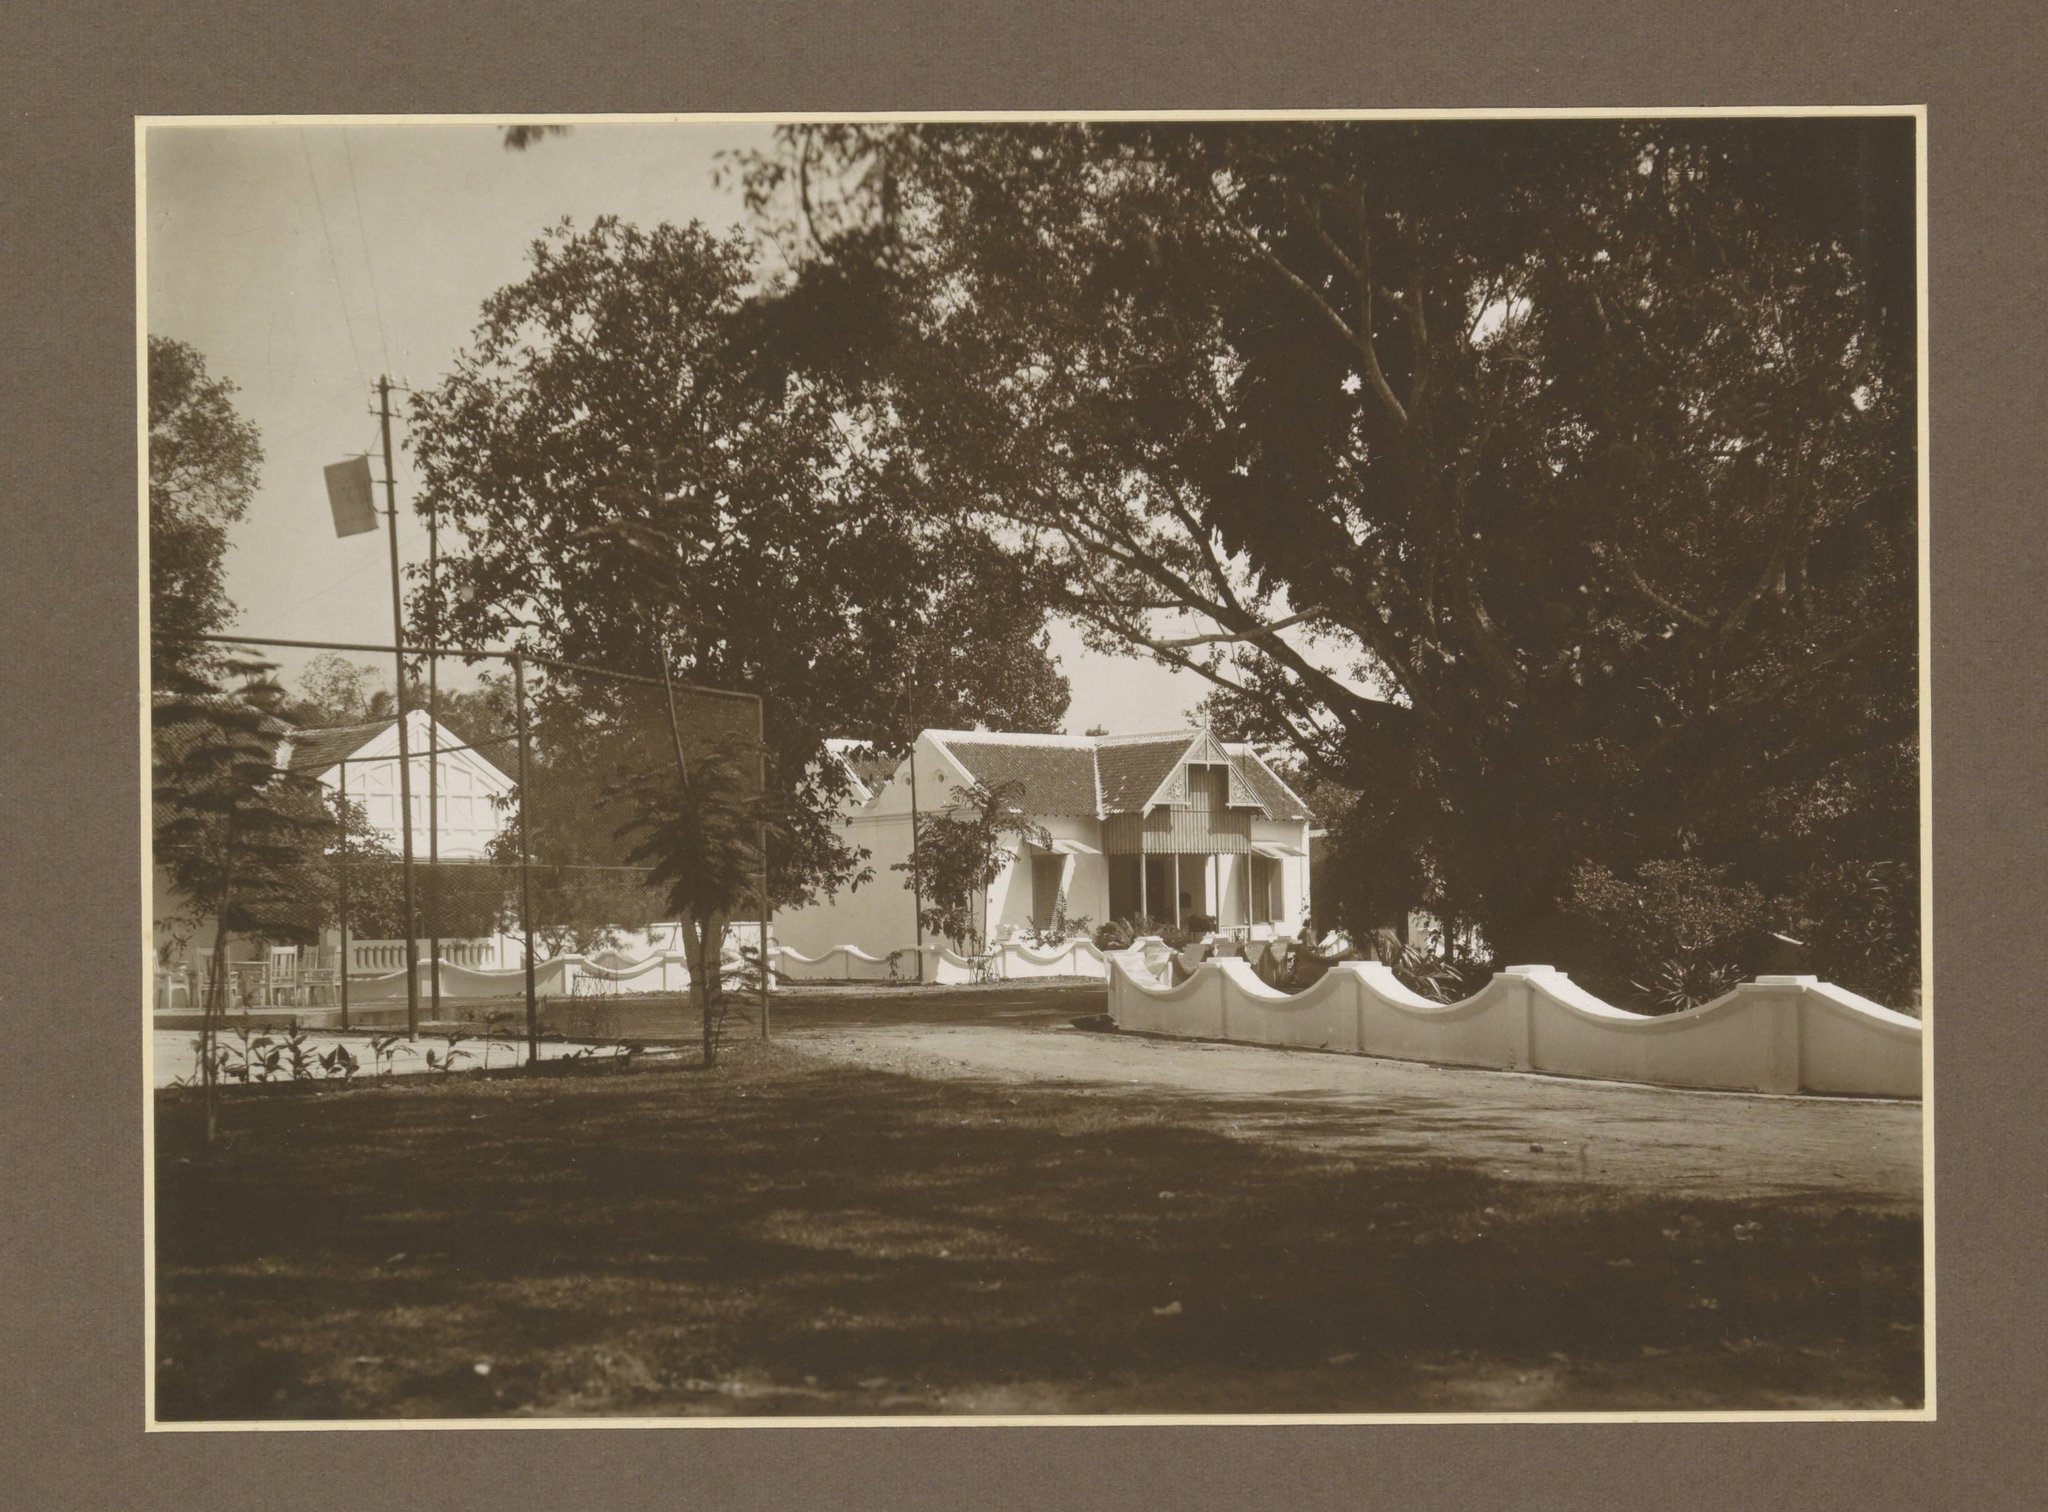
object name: photograph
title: Woningen met tennisbaan voor werknemers van suikerfabriek Goedo te Djombang op Java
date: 1925-1930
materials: cardboard, paper, photographic support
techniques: gelatin silver print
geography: jombang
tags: plantation, tennis, lawn-tennis, rural housing, e.g. country-house, villa, cottage, plants and herbs: sugarcane, sugar, dutch east indies, the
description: Onderdeel van Fotoalbum met opnames van vier suikerfabrieken op Java.